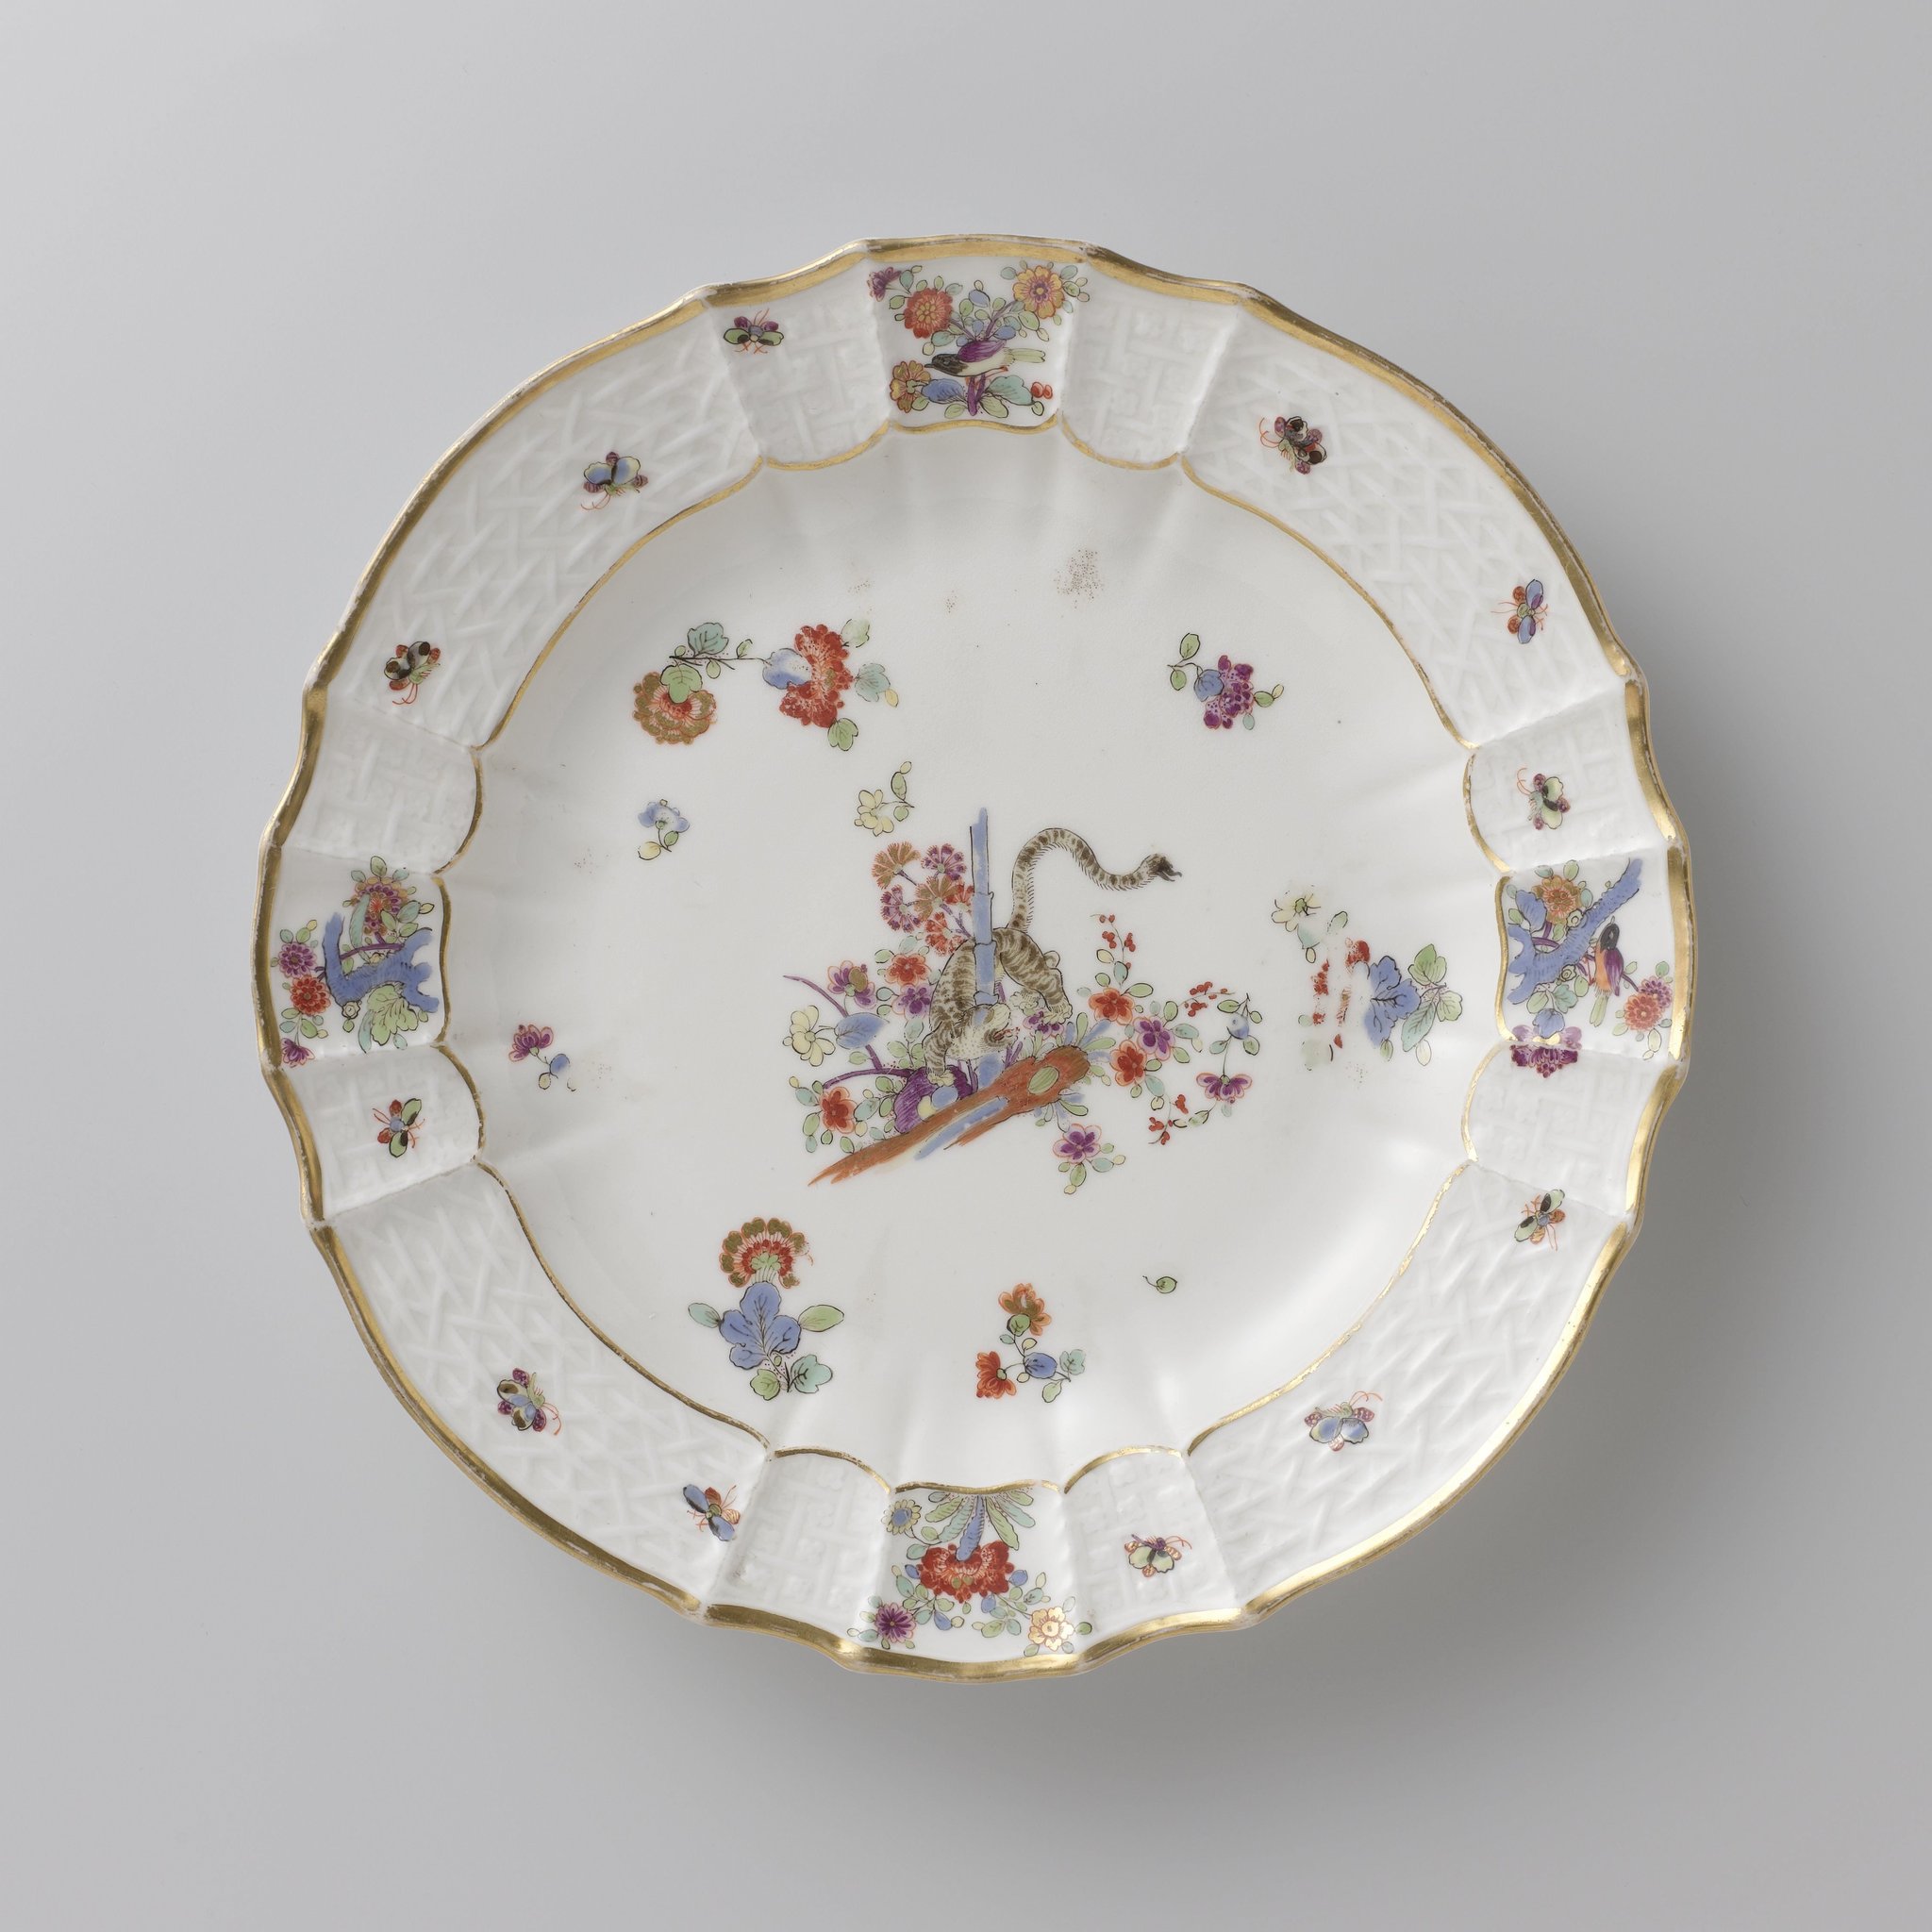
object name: plate dish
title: Rond bord, veelkleurig beschilderd met een Kakiemon-decor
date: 1740-1745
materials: porcelain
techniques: painted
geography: meissen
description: Rond bord van beschilderd porselein. Het bord is geribd en heeft een geschulpte rand. Het bord is beschilderd met een tijger die om een blauwe bamboestengel tussen bloemen is gedraaid, gestrooide Indianische Blumen, vlinders en takken waarop vogels. De rand is versierd met het 'Altbrandenstein'-patroon. Het bord is gemerkt.